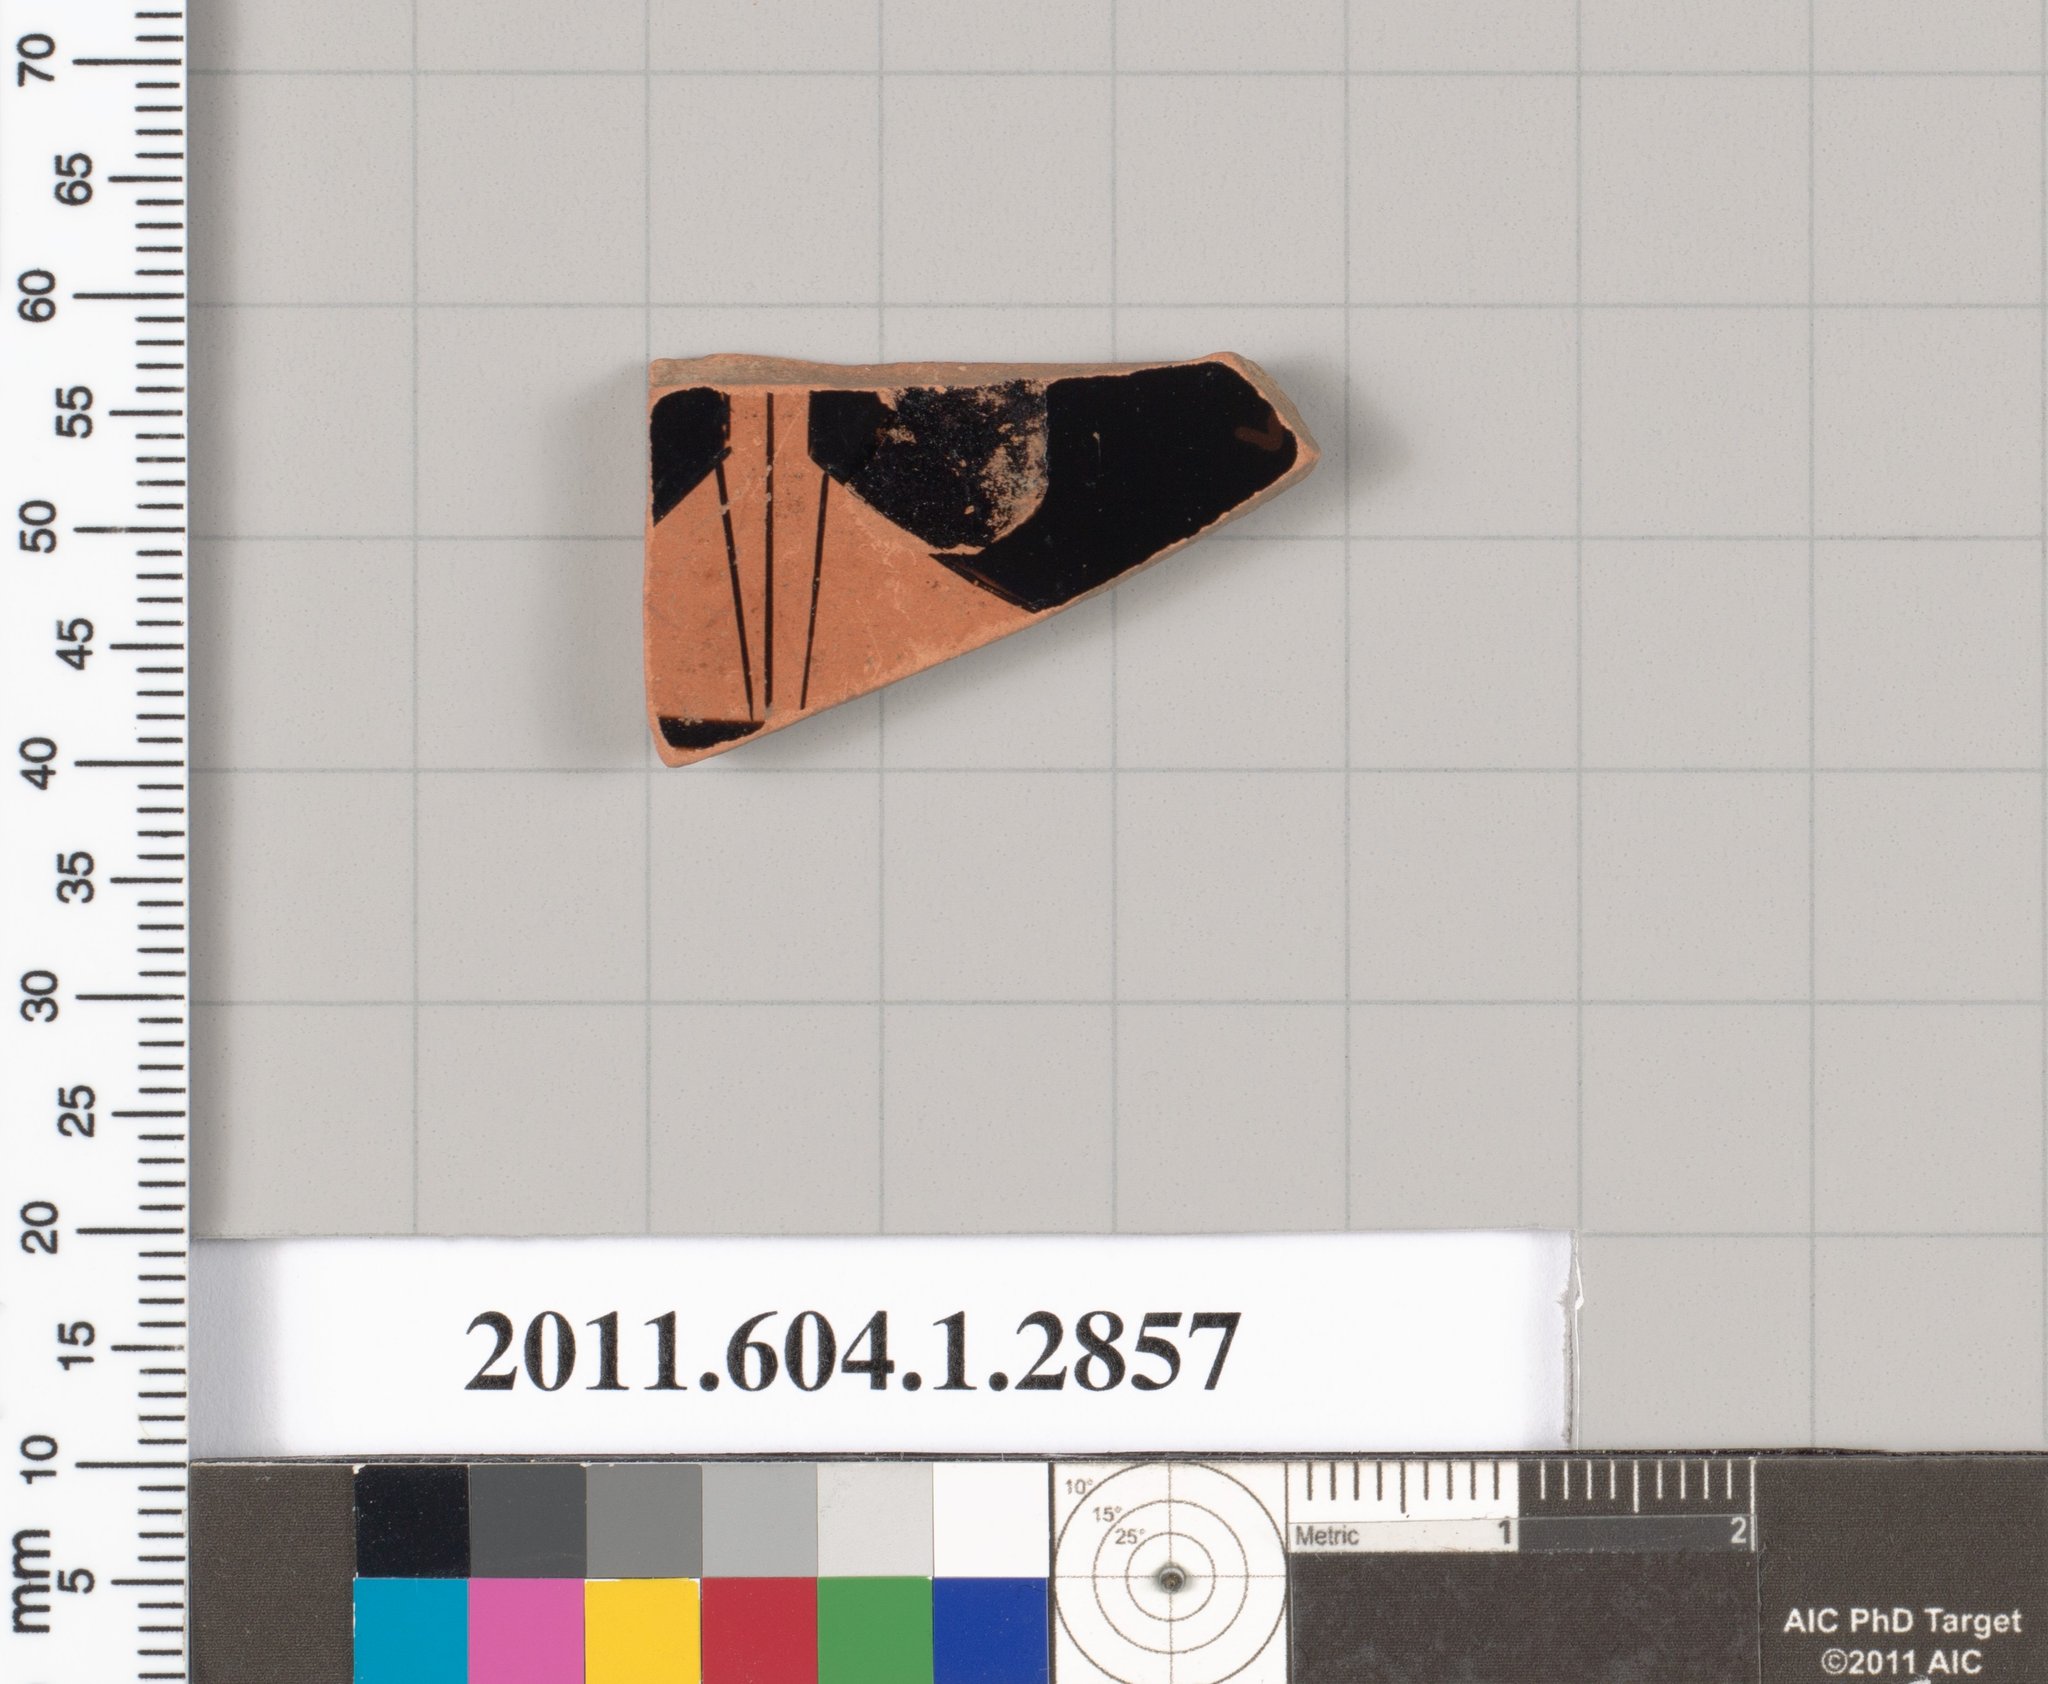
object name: kylix fragment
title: Terracotta fragment of a kylix (drinking cup)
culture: greek, attic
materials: terracotta